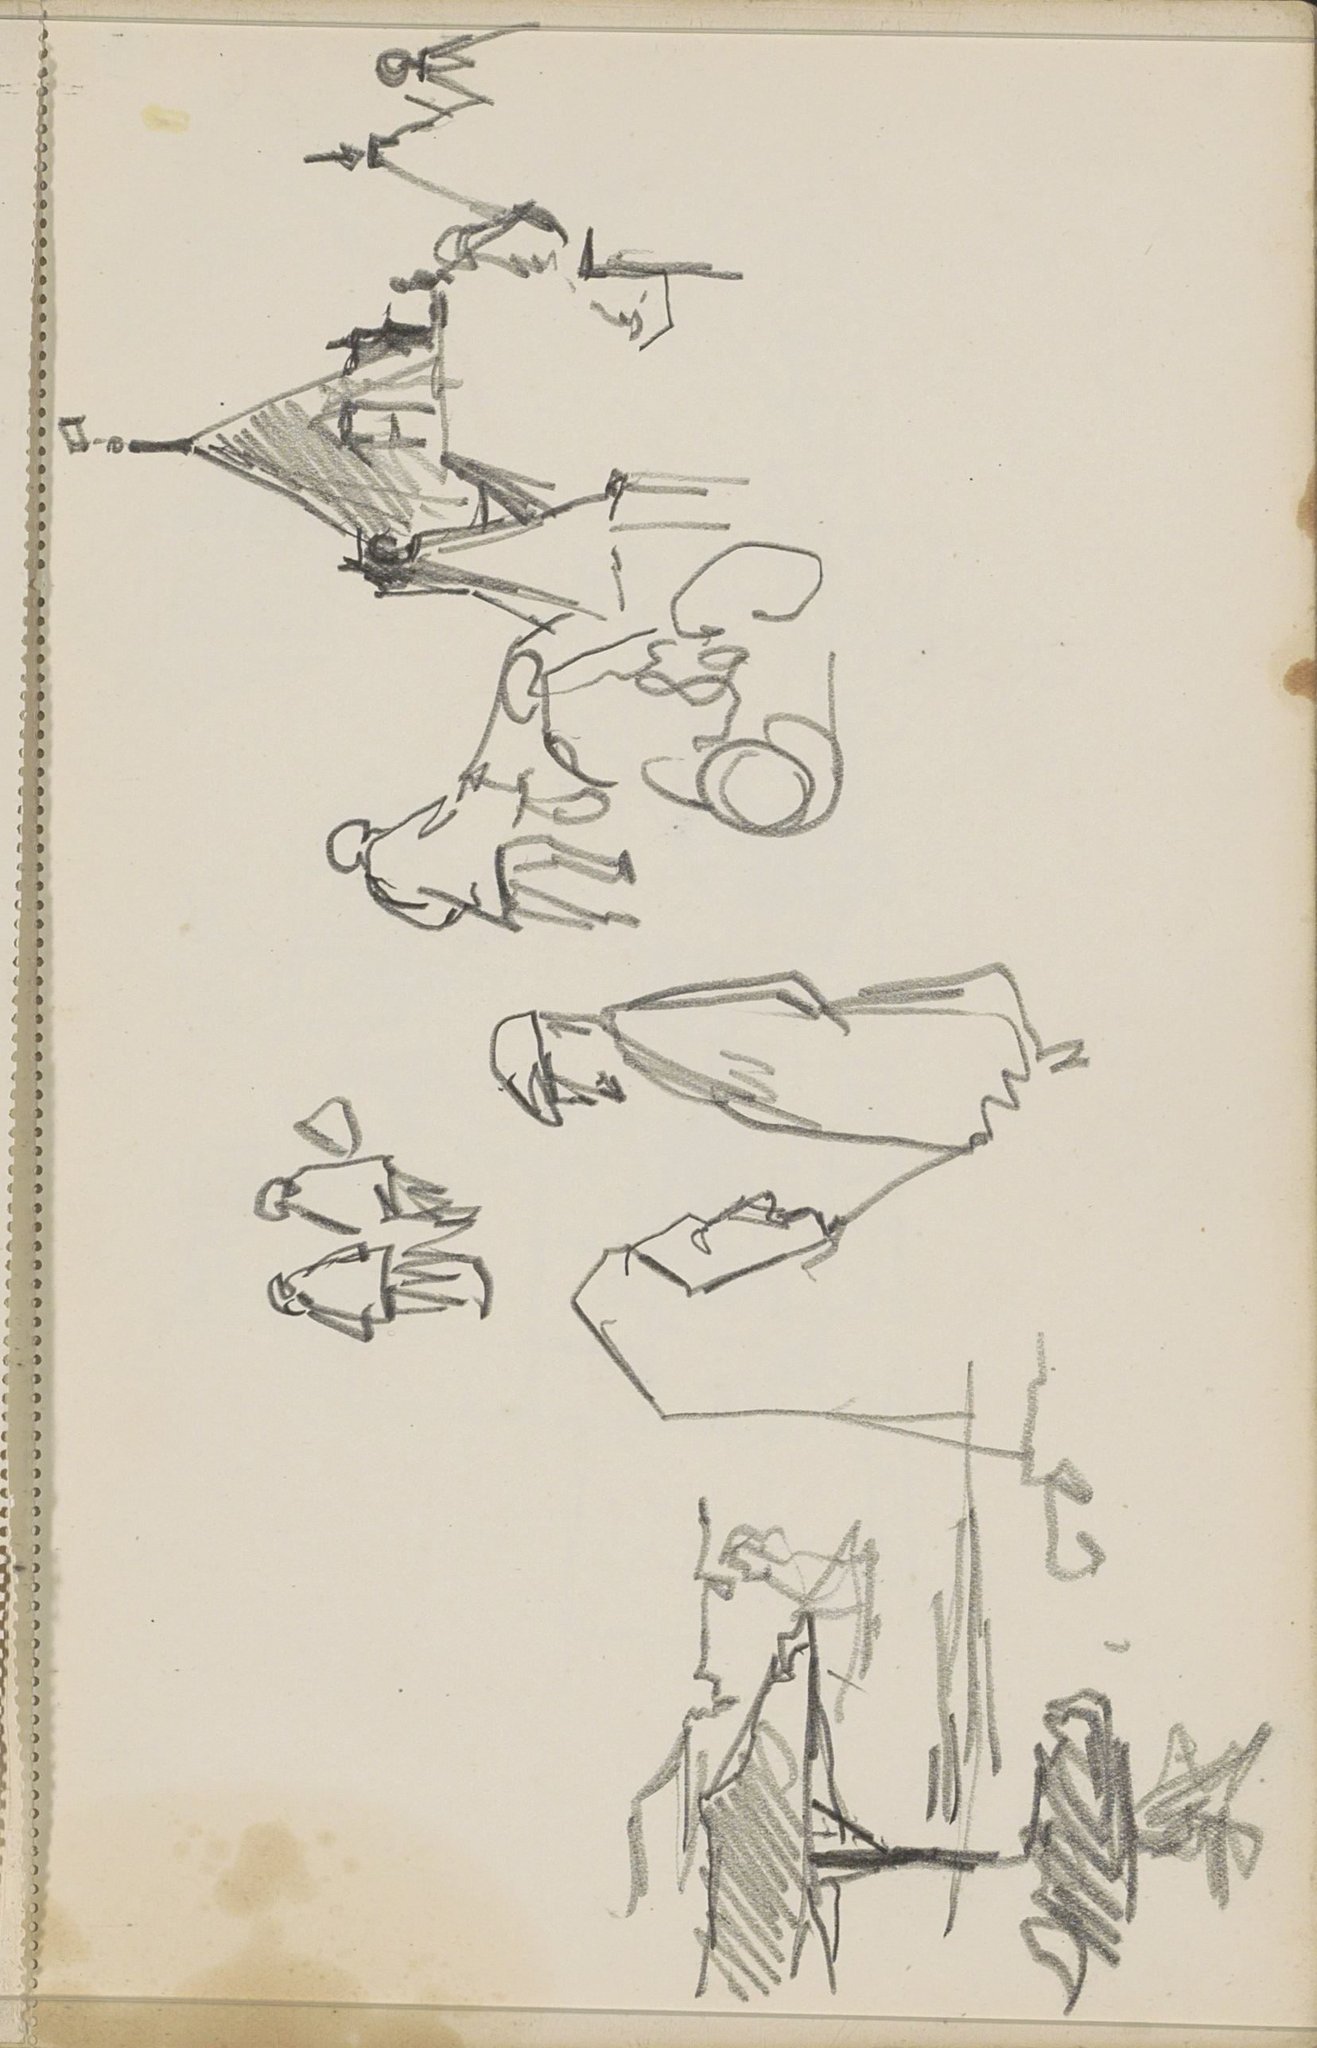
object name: sketchbook leaf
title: Figuurstudies en de torens van de Waag te Amsterdam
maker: cornelis vreedenburgh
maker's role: draughtsman, print maker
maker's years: 1880-1946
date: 1890-1946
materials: paper, pencil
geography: amsterdam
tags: civic architecture; edifices; dwellings, street (+ city(-scape) with figures, staffage)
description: Blad 8 recto uit een schetsboek met 59 bladen.